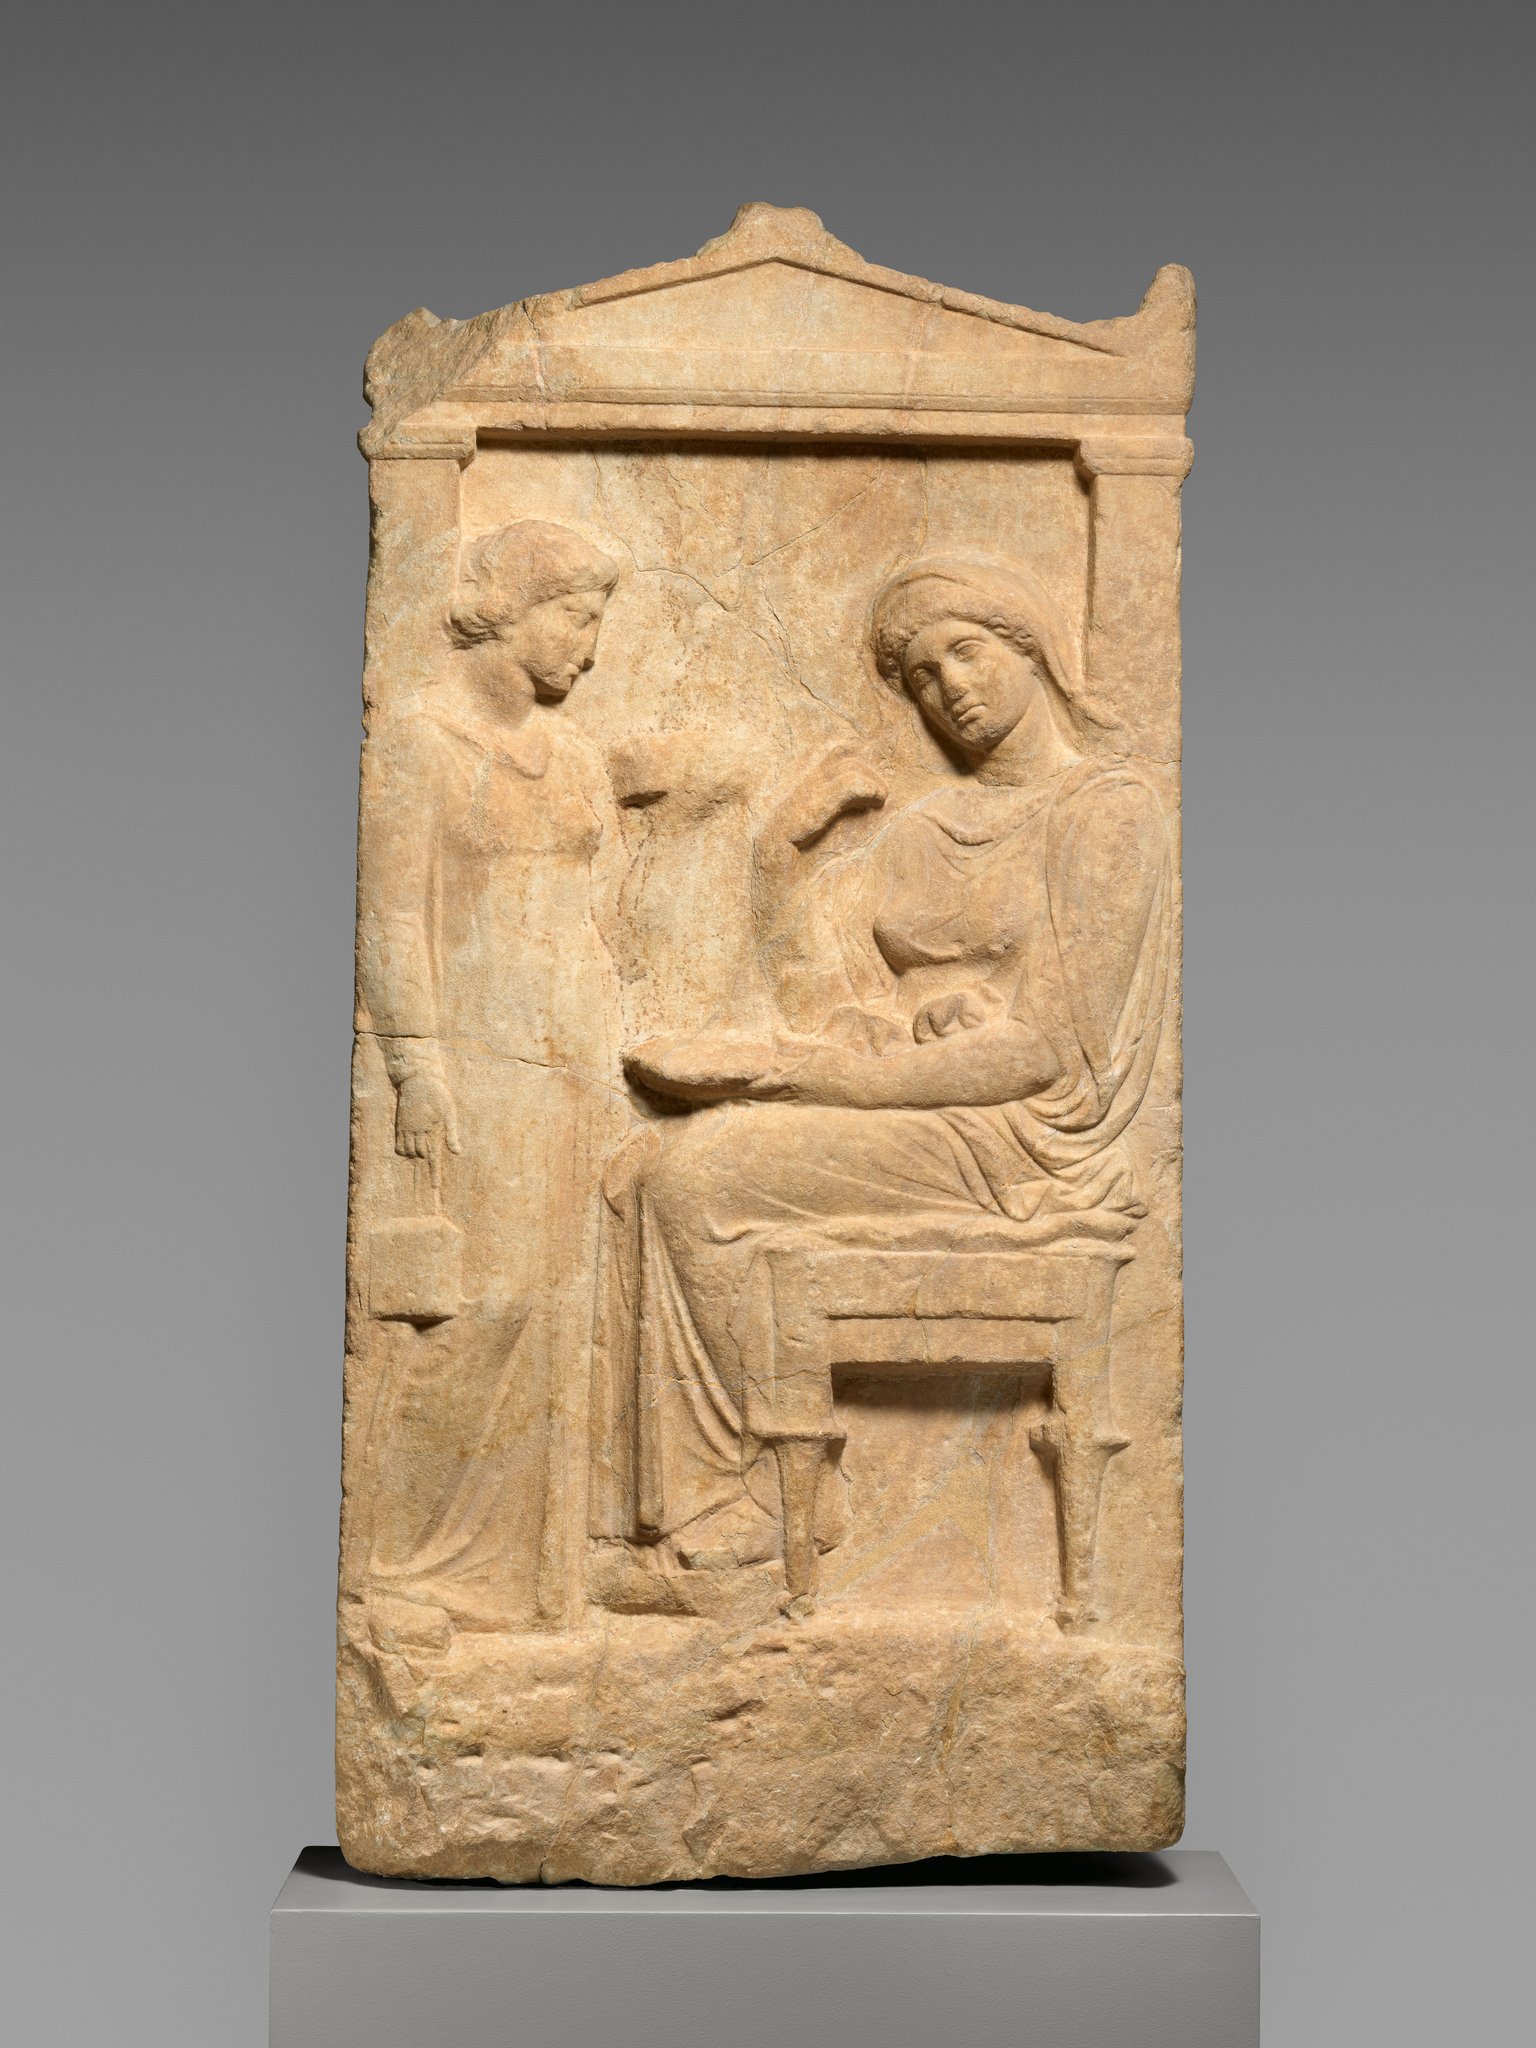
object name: grave stele of phainippe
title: Marble stele (grave marker) of Phainippe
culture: greek, attic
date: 400-390 BCE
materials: marble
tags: girls,women,mirrors